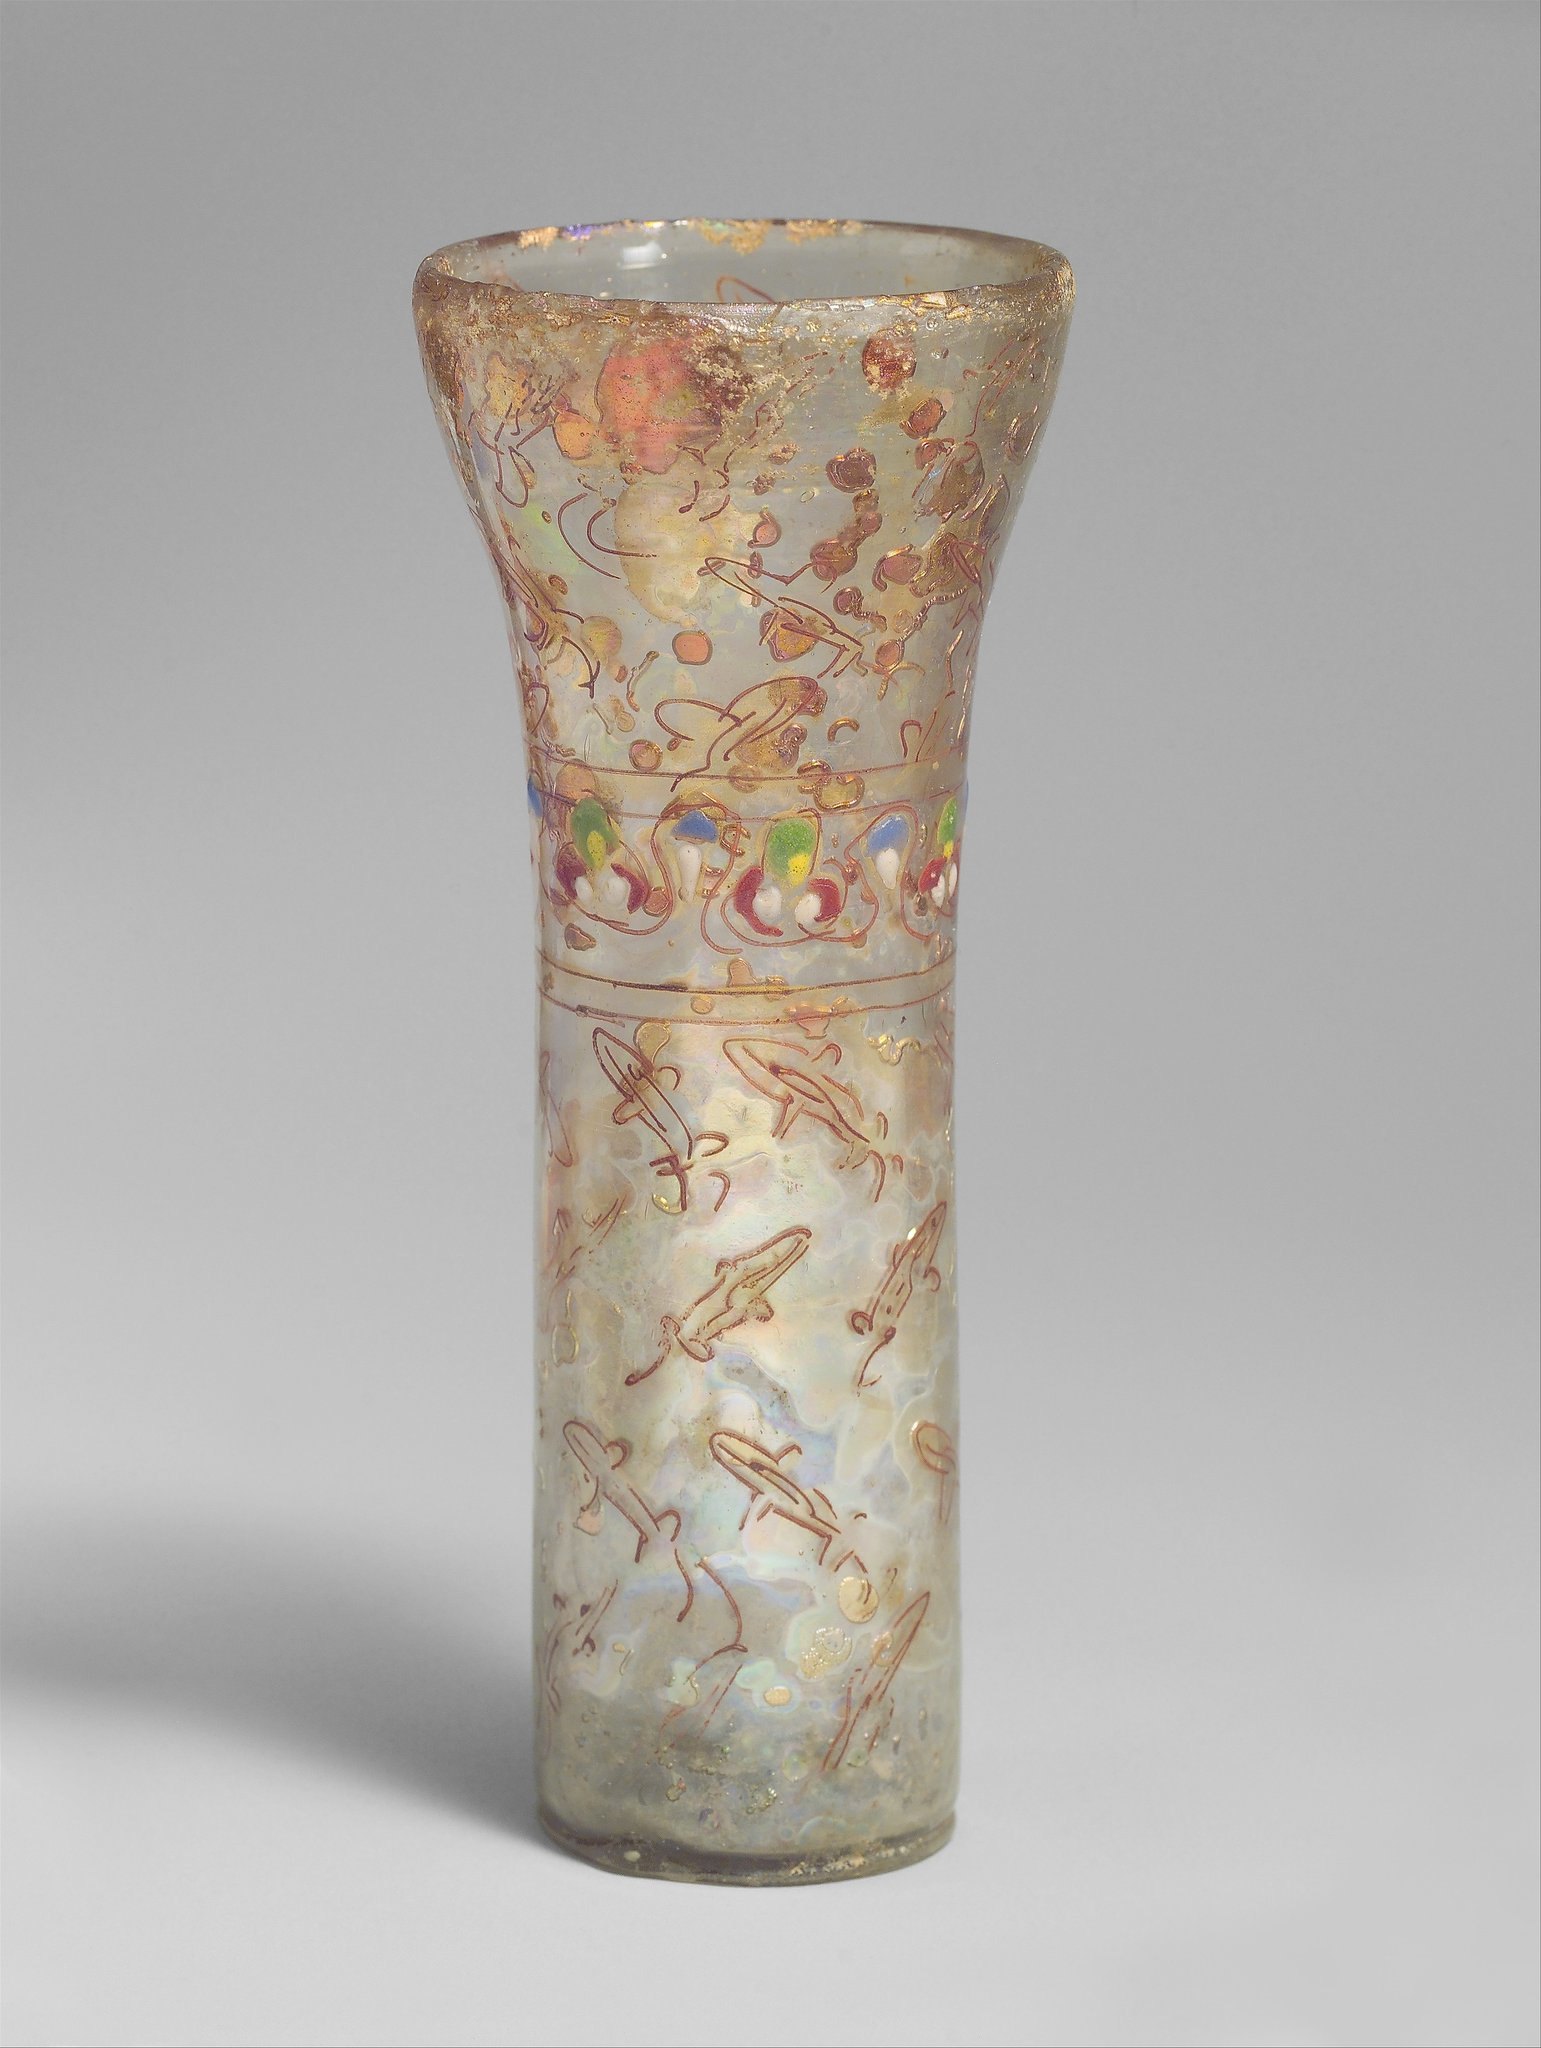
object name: beaker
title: Beaker with Fish Motifs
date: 1201-1400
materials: glass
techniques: glassblowing, enamel, gilding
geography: syria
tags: fish